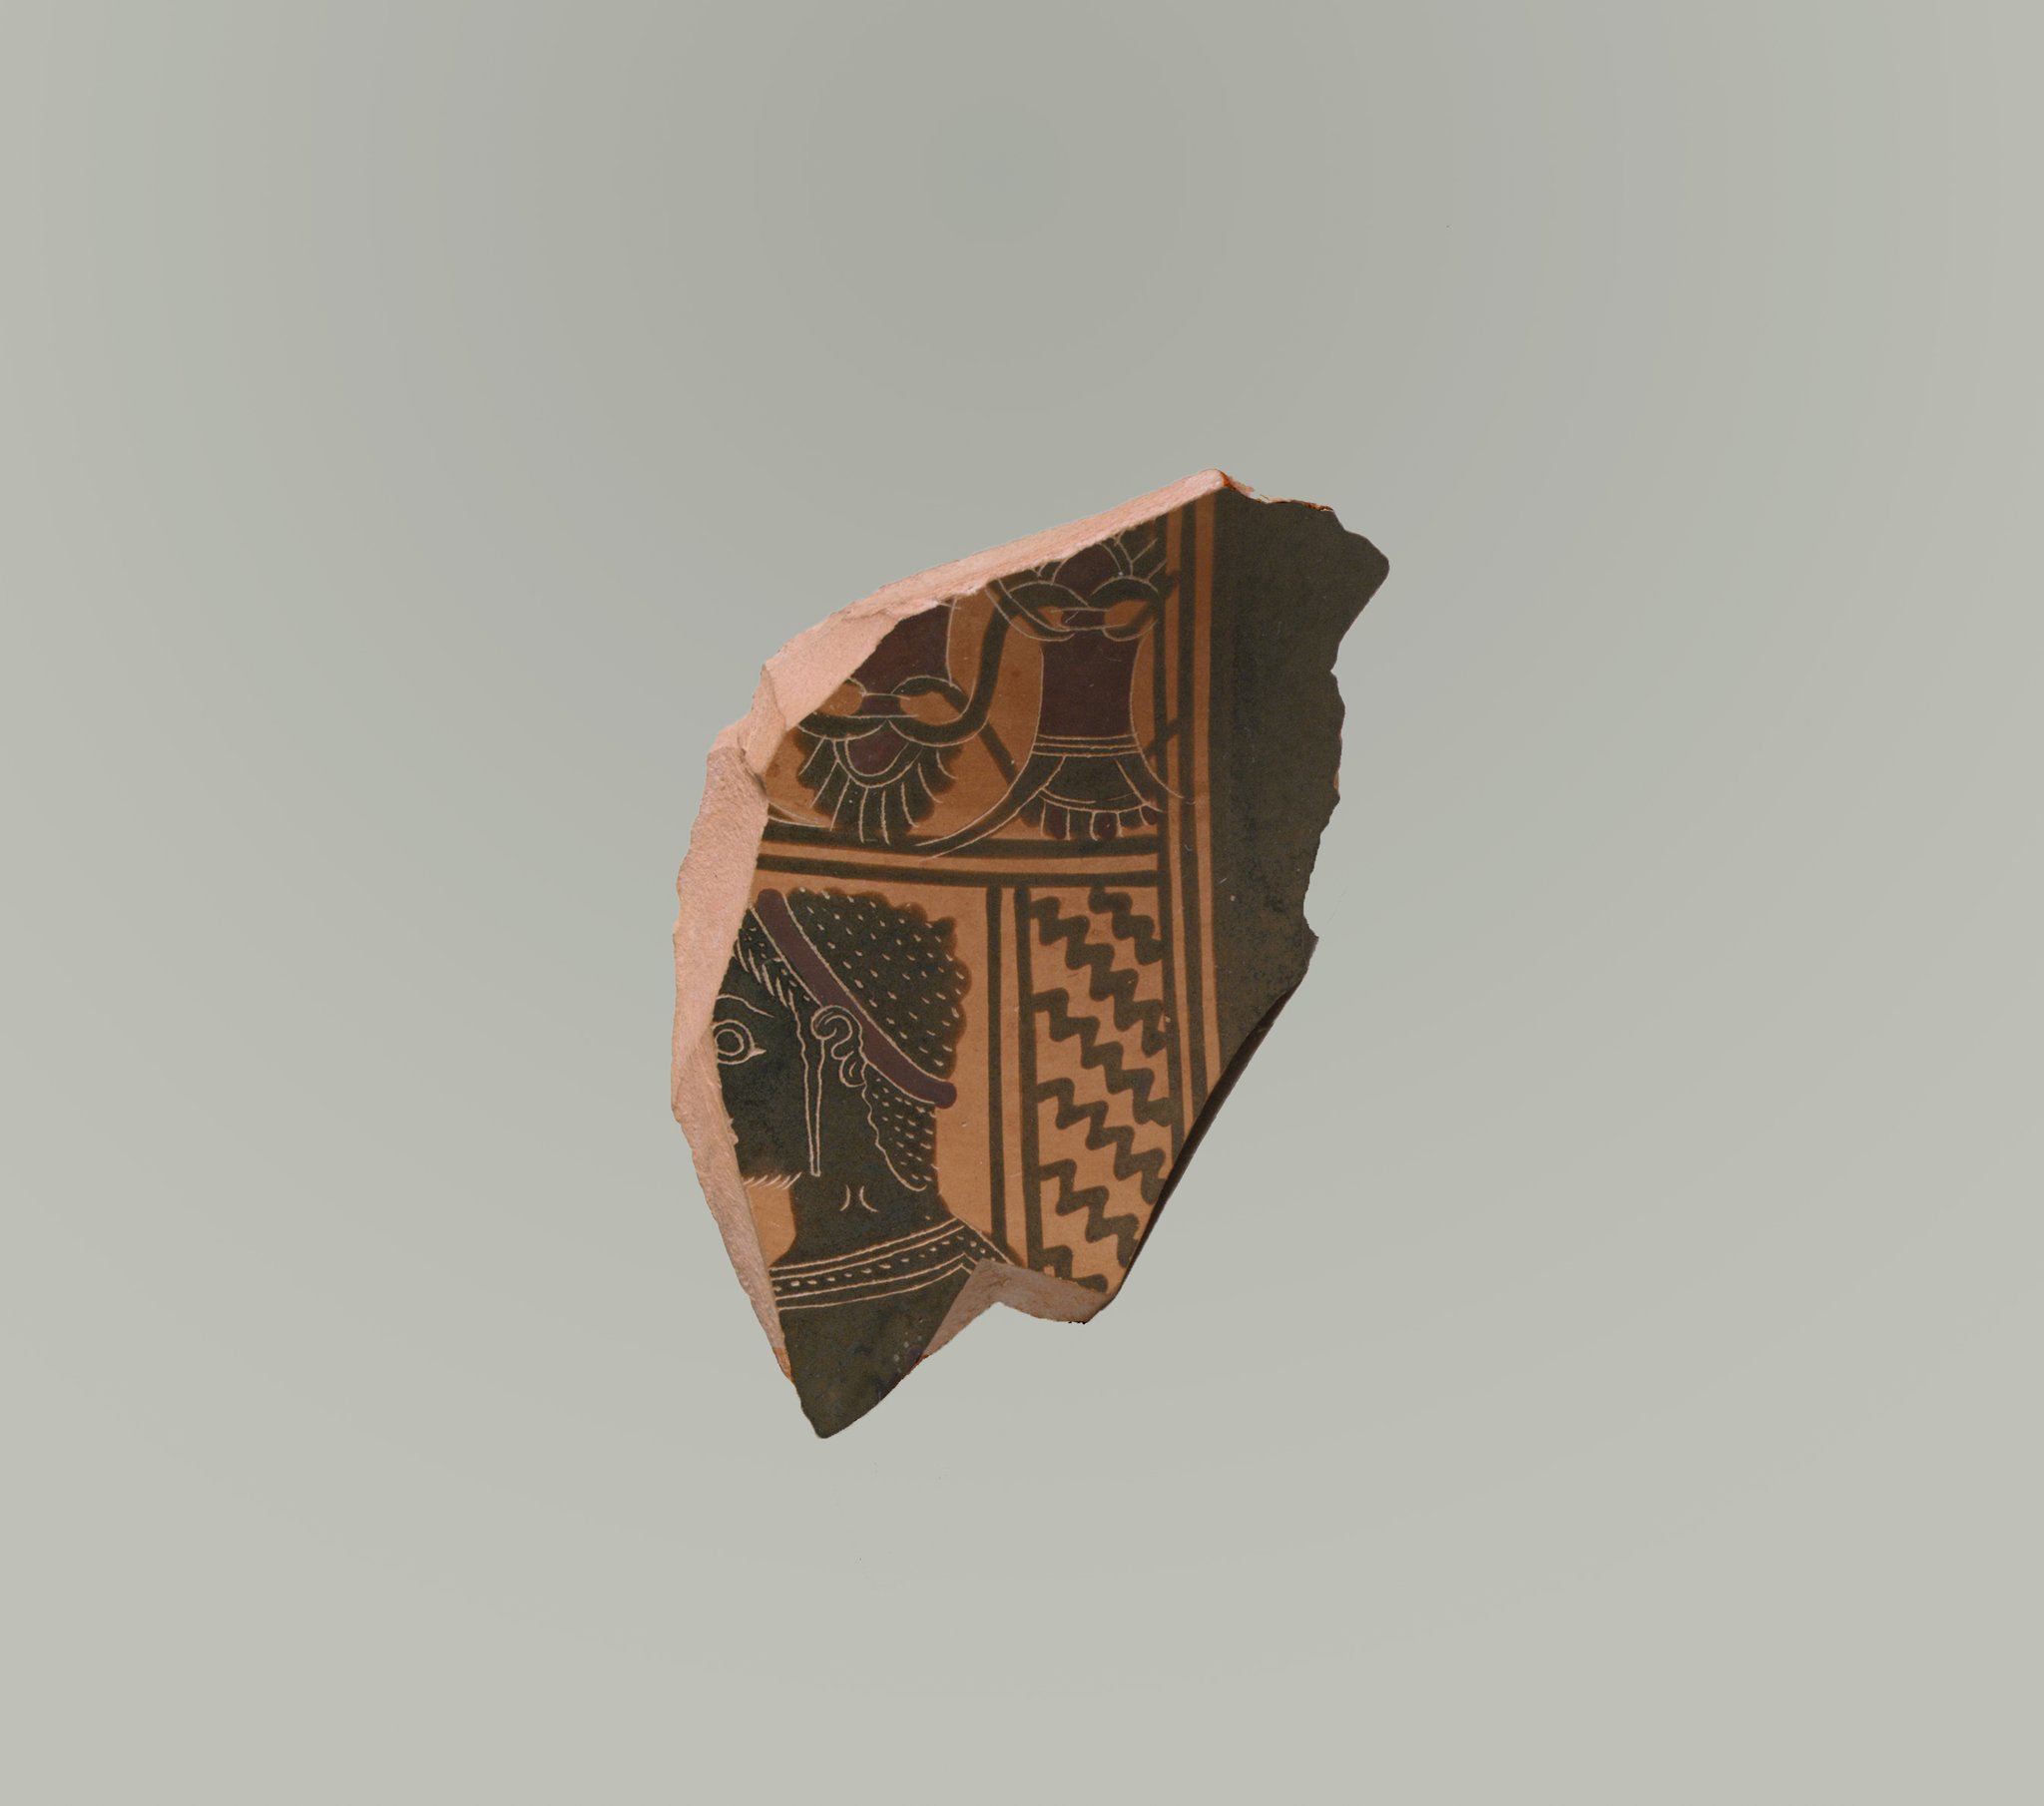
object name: amphora fragment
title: Fragment of a terracotta amphora (jar)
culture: greek, attic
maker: amasis painter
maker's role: artist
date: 550-540 BCE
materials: terracotta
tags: heads